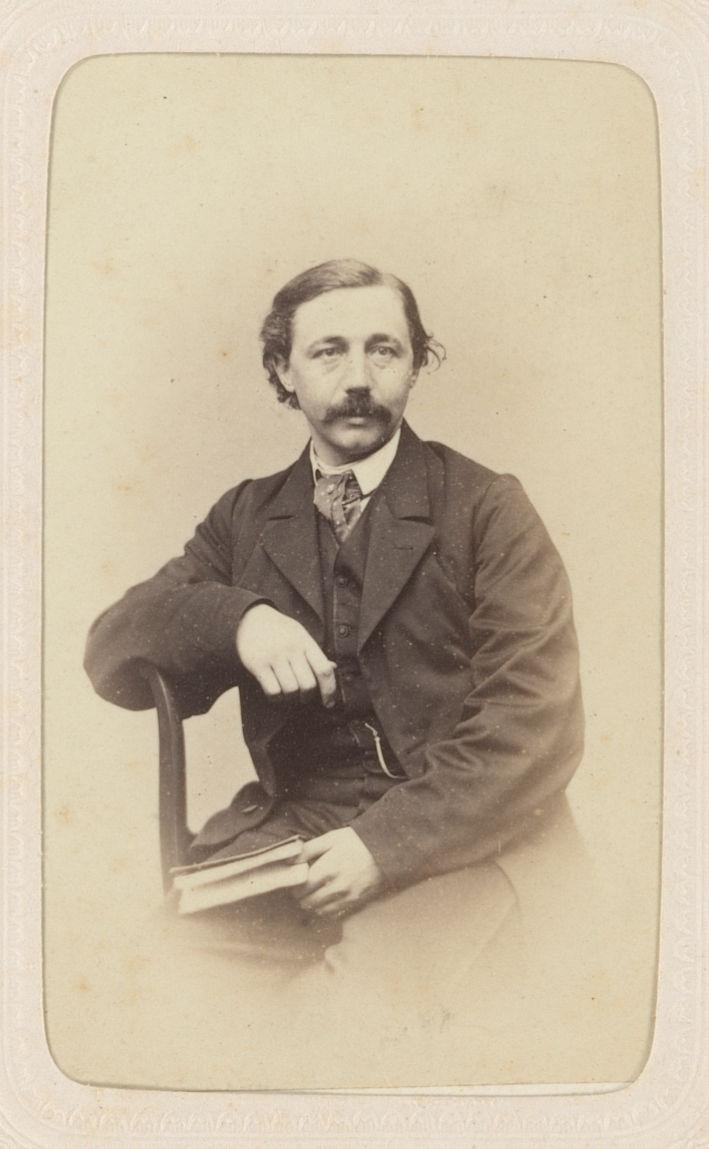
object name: carte de visite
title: Studioportret van een man met een snor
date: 1863-1866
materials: cardboard, paper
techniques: albumen print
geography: utrecht